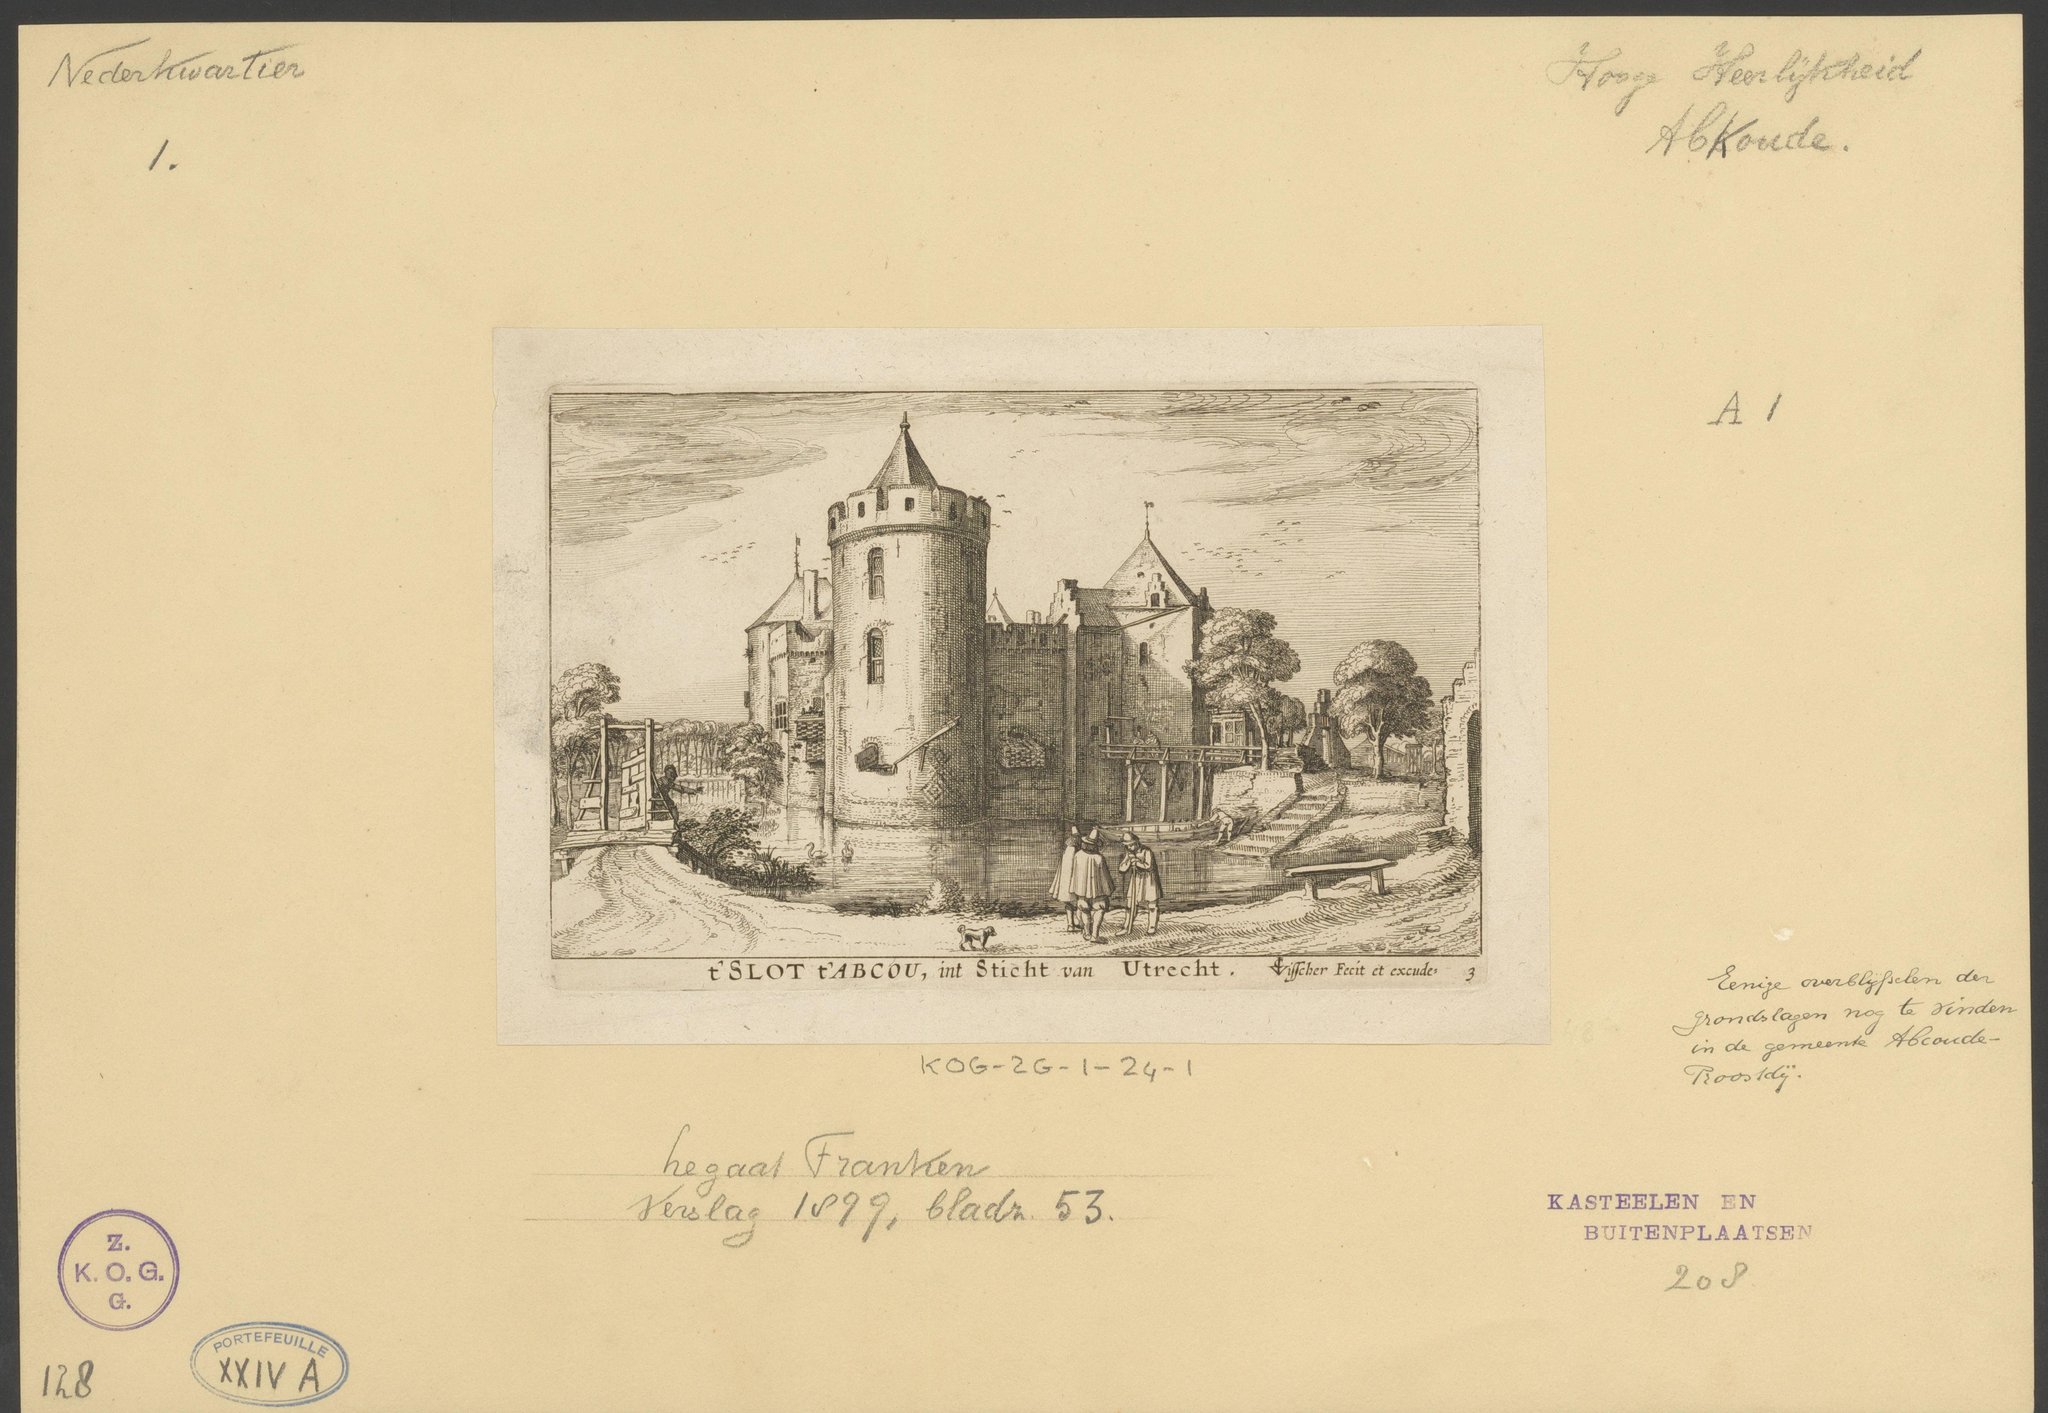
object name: print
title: t' Slot t' Abcou, int Sticht van Utrecht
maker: claes jansz. visscher (ii)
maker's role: draughtsman, print maker, publisher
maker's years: 1586-1652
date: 1617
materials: paper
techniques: engraving, etching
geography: amsterdam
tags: castle, conversation, dialogue; conversation piece, dog, utrecht, abcoude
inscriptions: stamp, collector's mark: Lugt 1641, stamp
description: Landschap met Slot Abcoude. Op de voorgrond drie figuren en een hond. Derde prent in een serie van vier met kastelen te Holland en Utrecht. Onderwerpsrubrieken binnen de Atlas Zeden en Gewoonten: Zeden en Gewoonten in Engeren Zin, De Woning. Kastelen en buitenplaatsen. Utrecht (vervolg.).